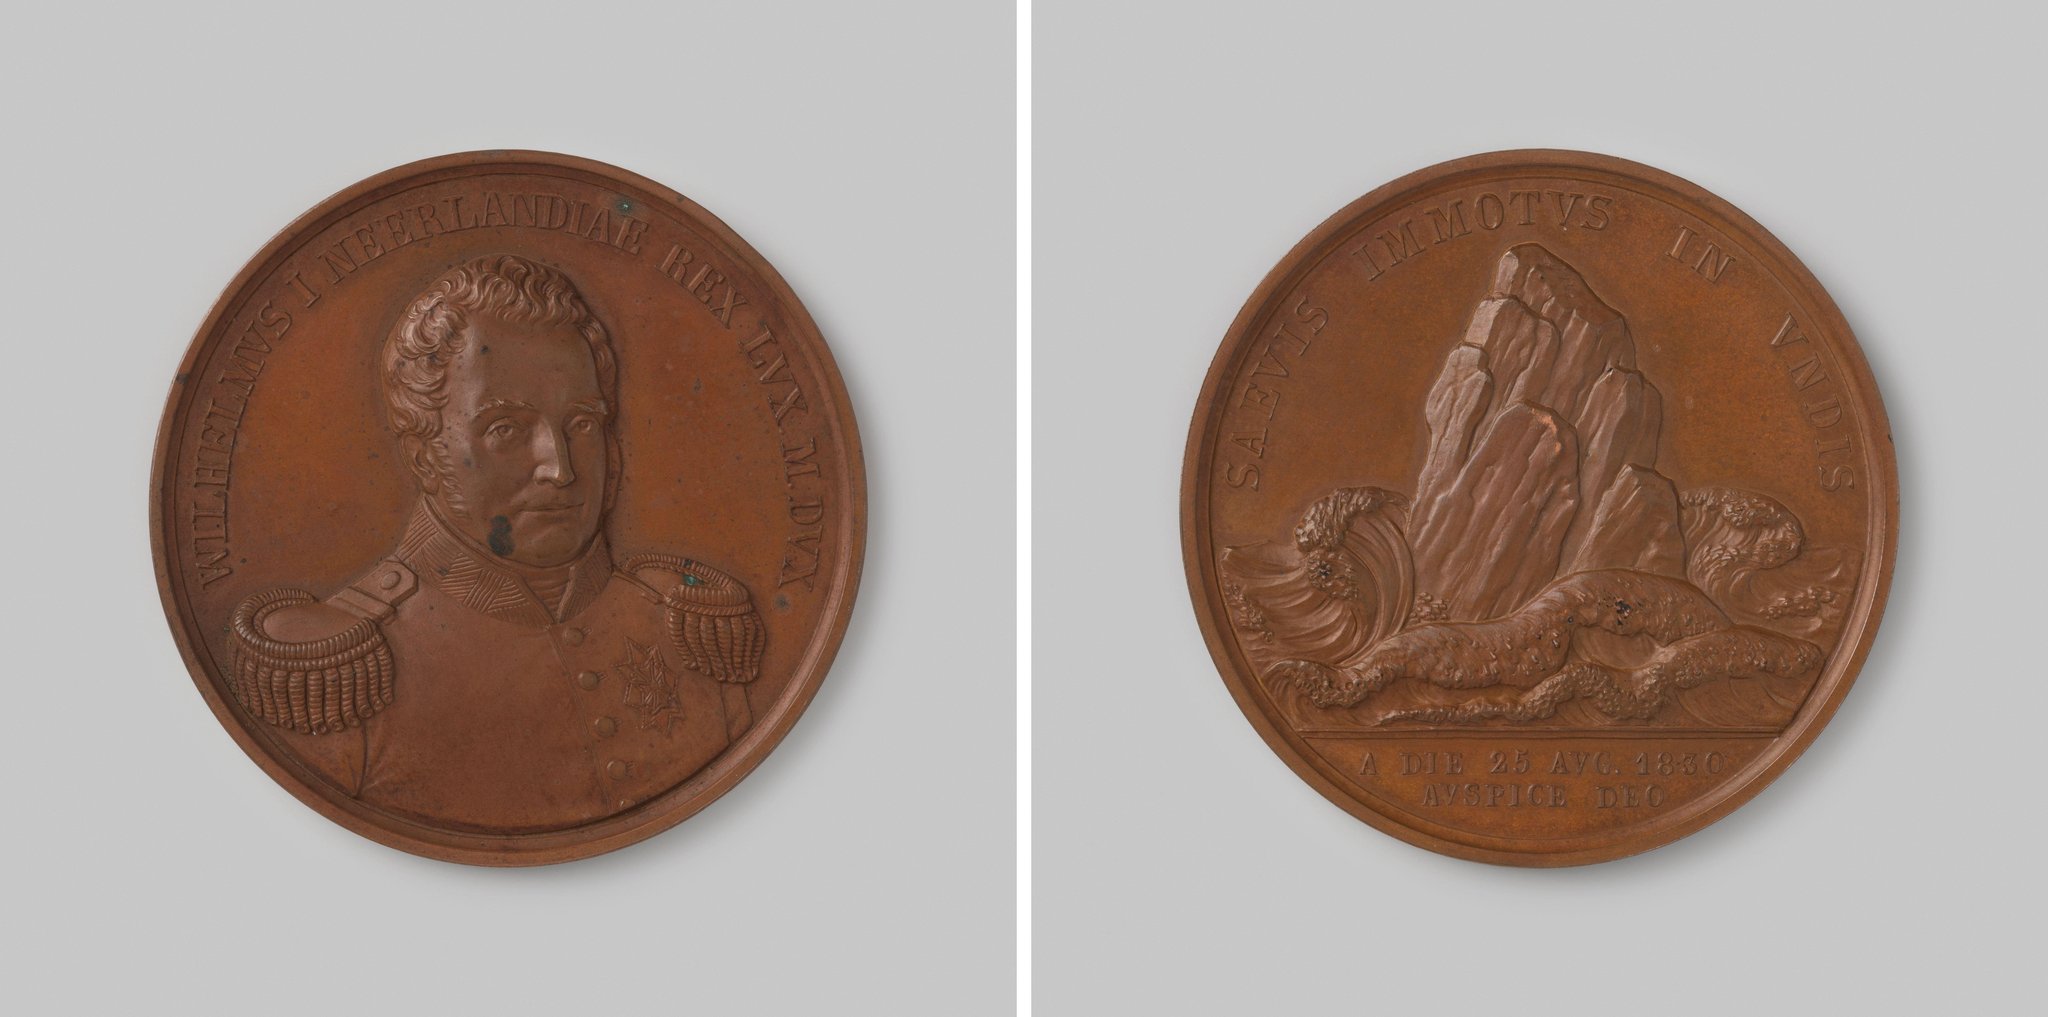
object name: history medal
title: De onwrikbaarheid van Koning Willem I 1830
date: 1830-1834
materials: bronze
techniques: striking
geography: berlin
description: Bronzen penning, op de voorzijde het borstbeeld van Willem I half naar rechts met omschrift, op de keerzijde een rots te midden van de golven, met omschrift en afsnedetekst.